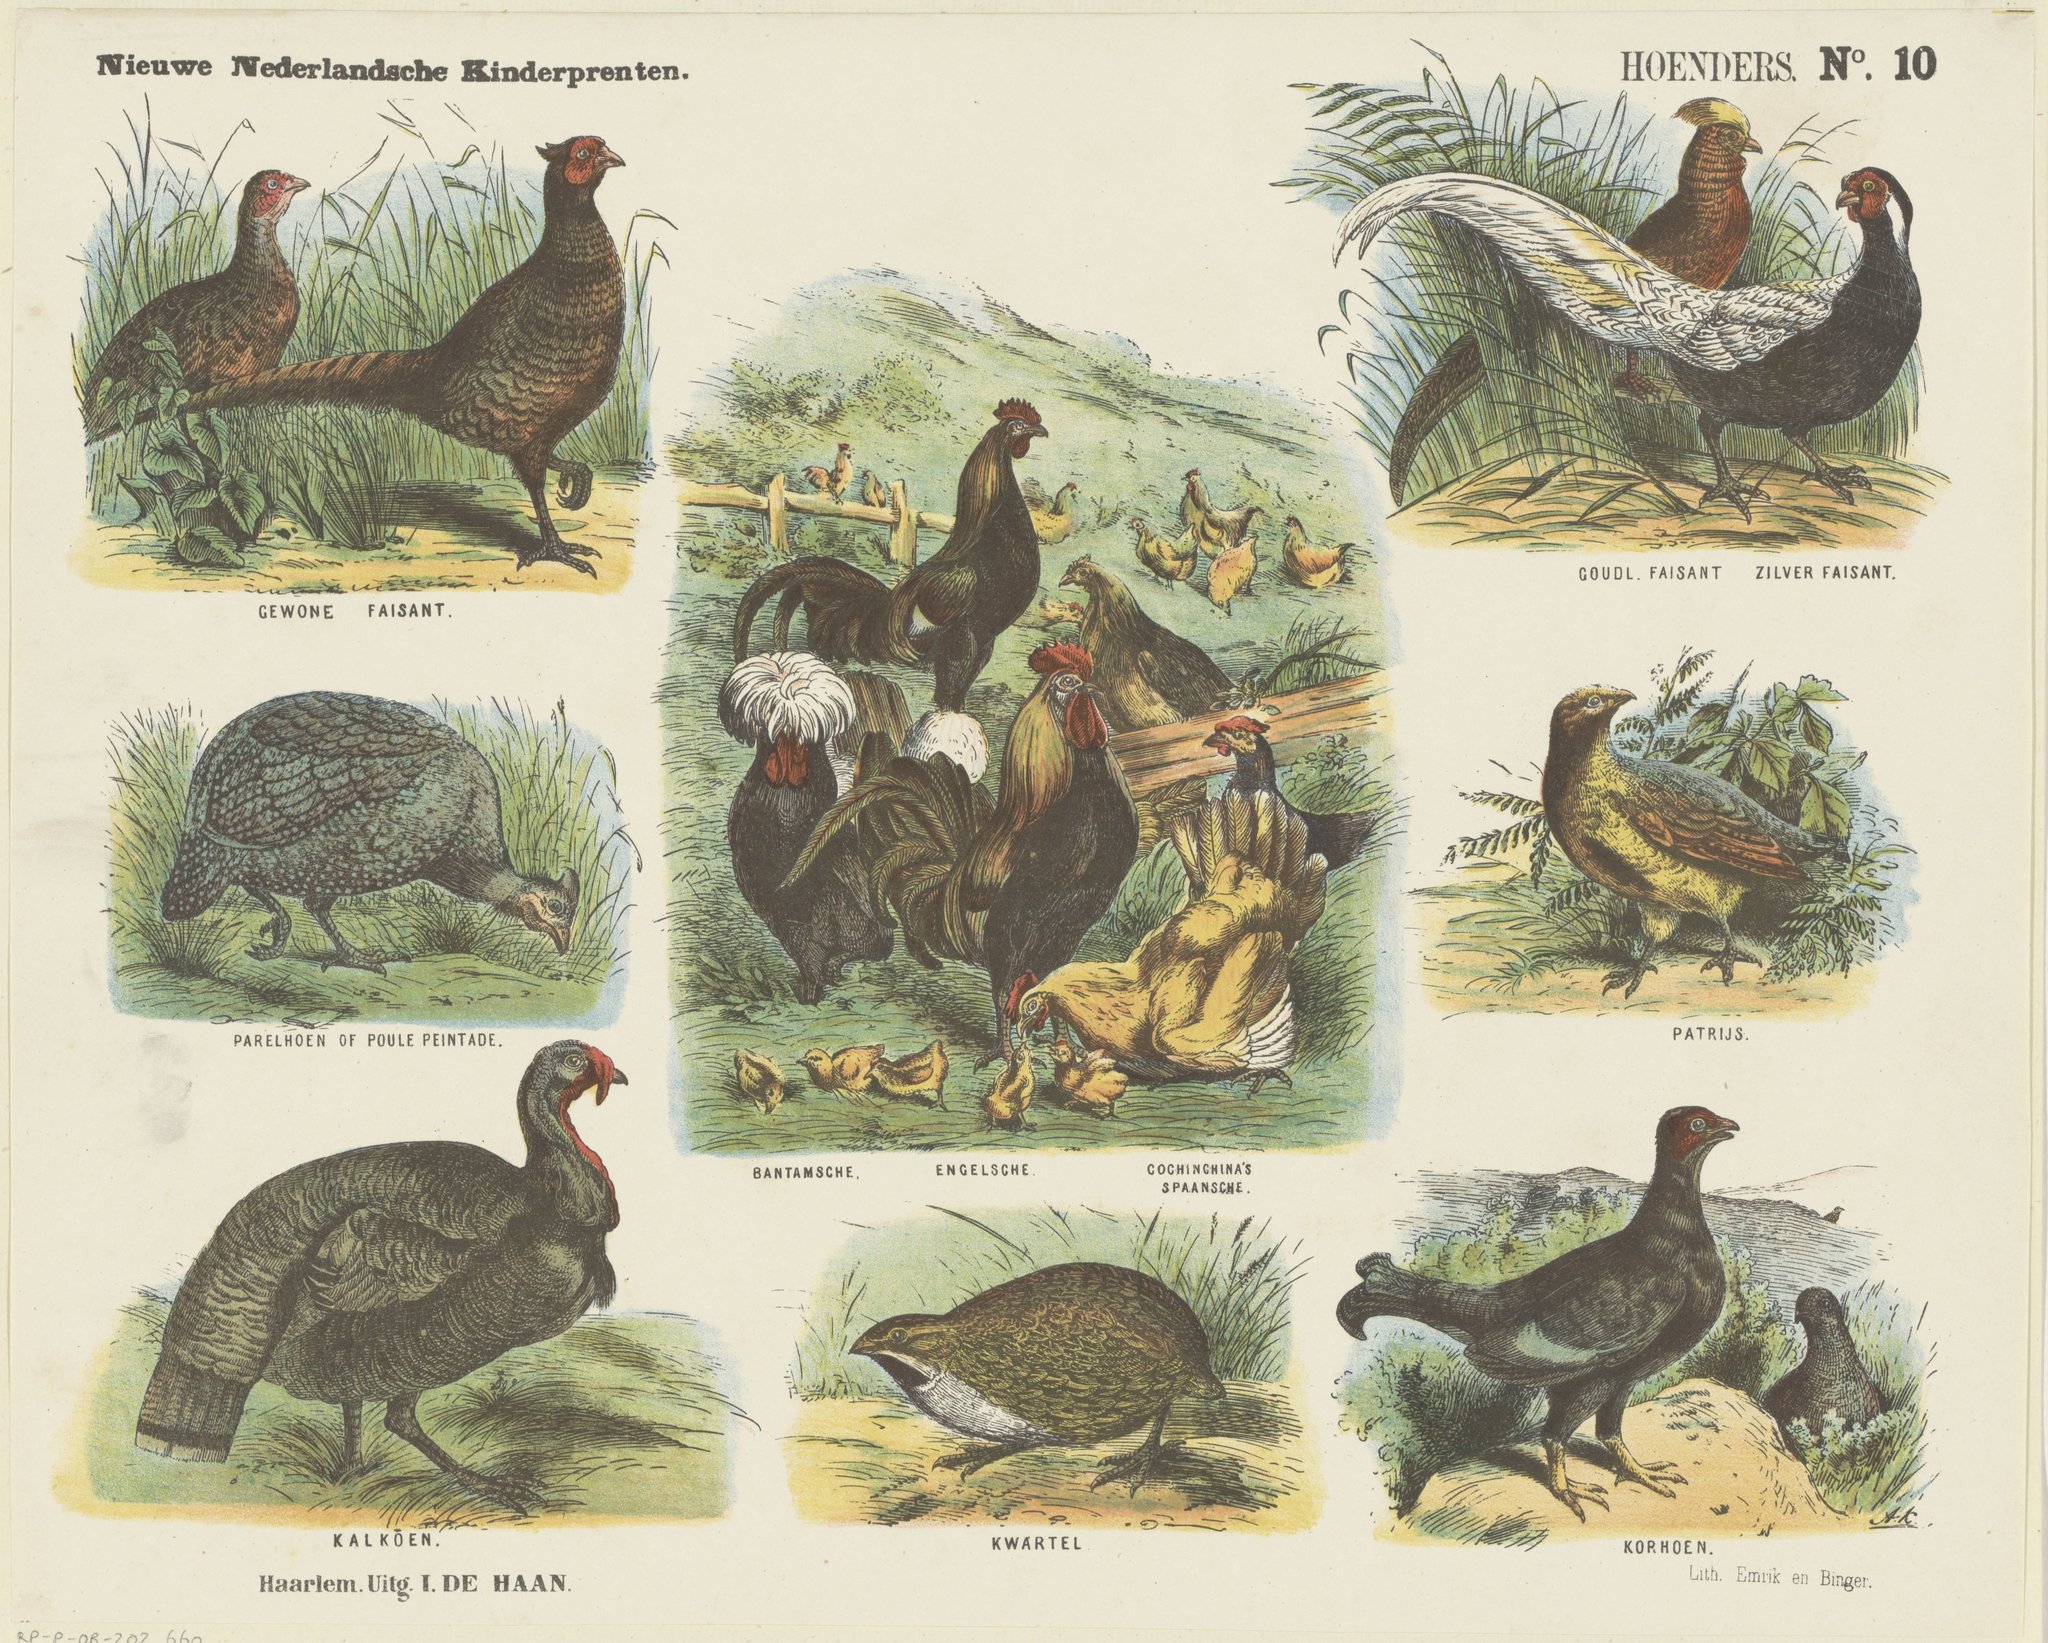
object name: print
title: Nieuwe Nederlandsche kinderprenten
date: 1875-1903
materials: paper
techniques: lithograph, letterpress printing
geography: haarlem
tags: walker and runner birds, walker and runner birds: pheasant, fowl (cock, hen, chicken, etc.), walker and runner birds: turkey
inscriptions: collector's mark: Lugt 2760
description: Blad met 8 voorstellingen van hoendervogels, onder andere een fazant, een kalkoen en een kwartel. Onder elke afbeelding een onderschrift. Genummerd rechtsboven: No. 10.